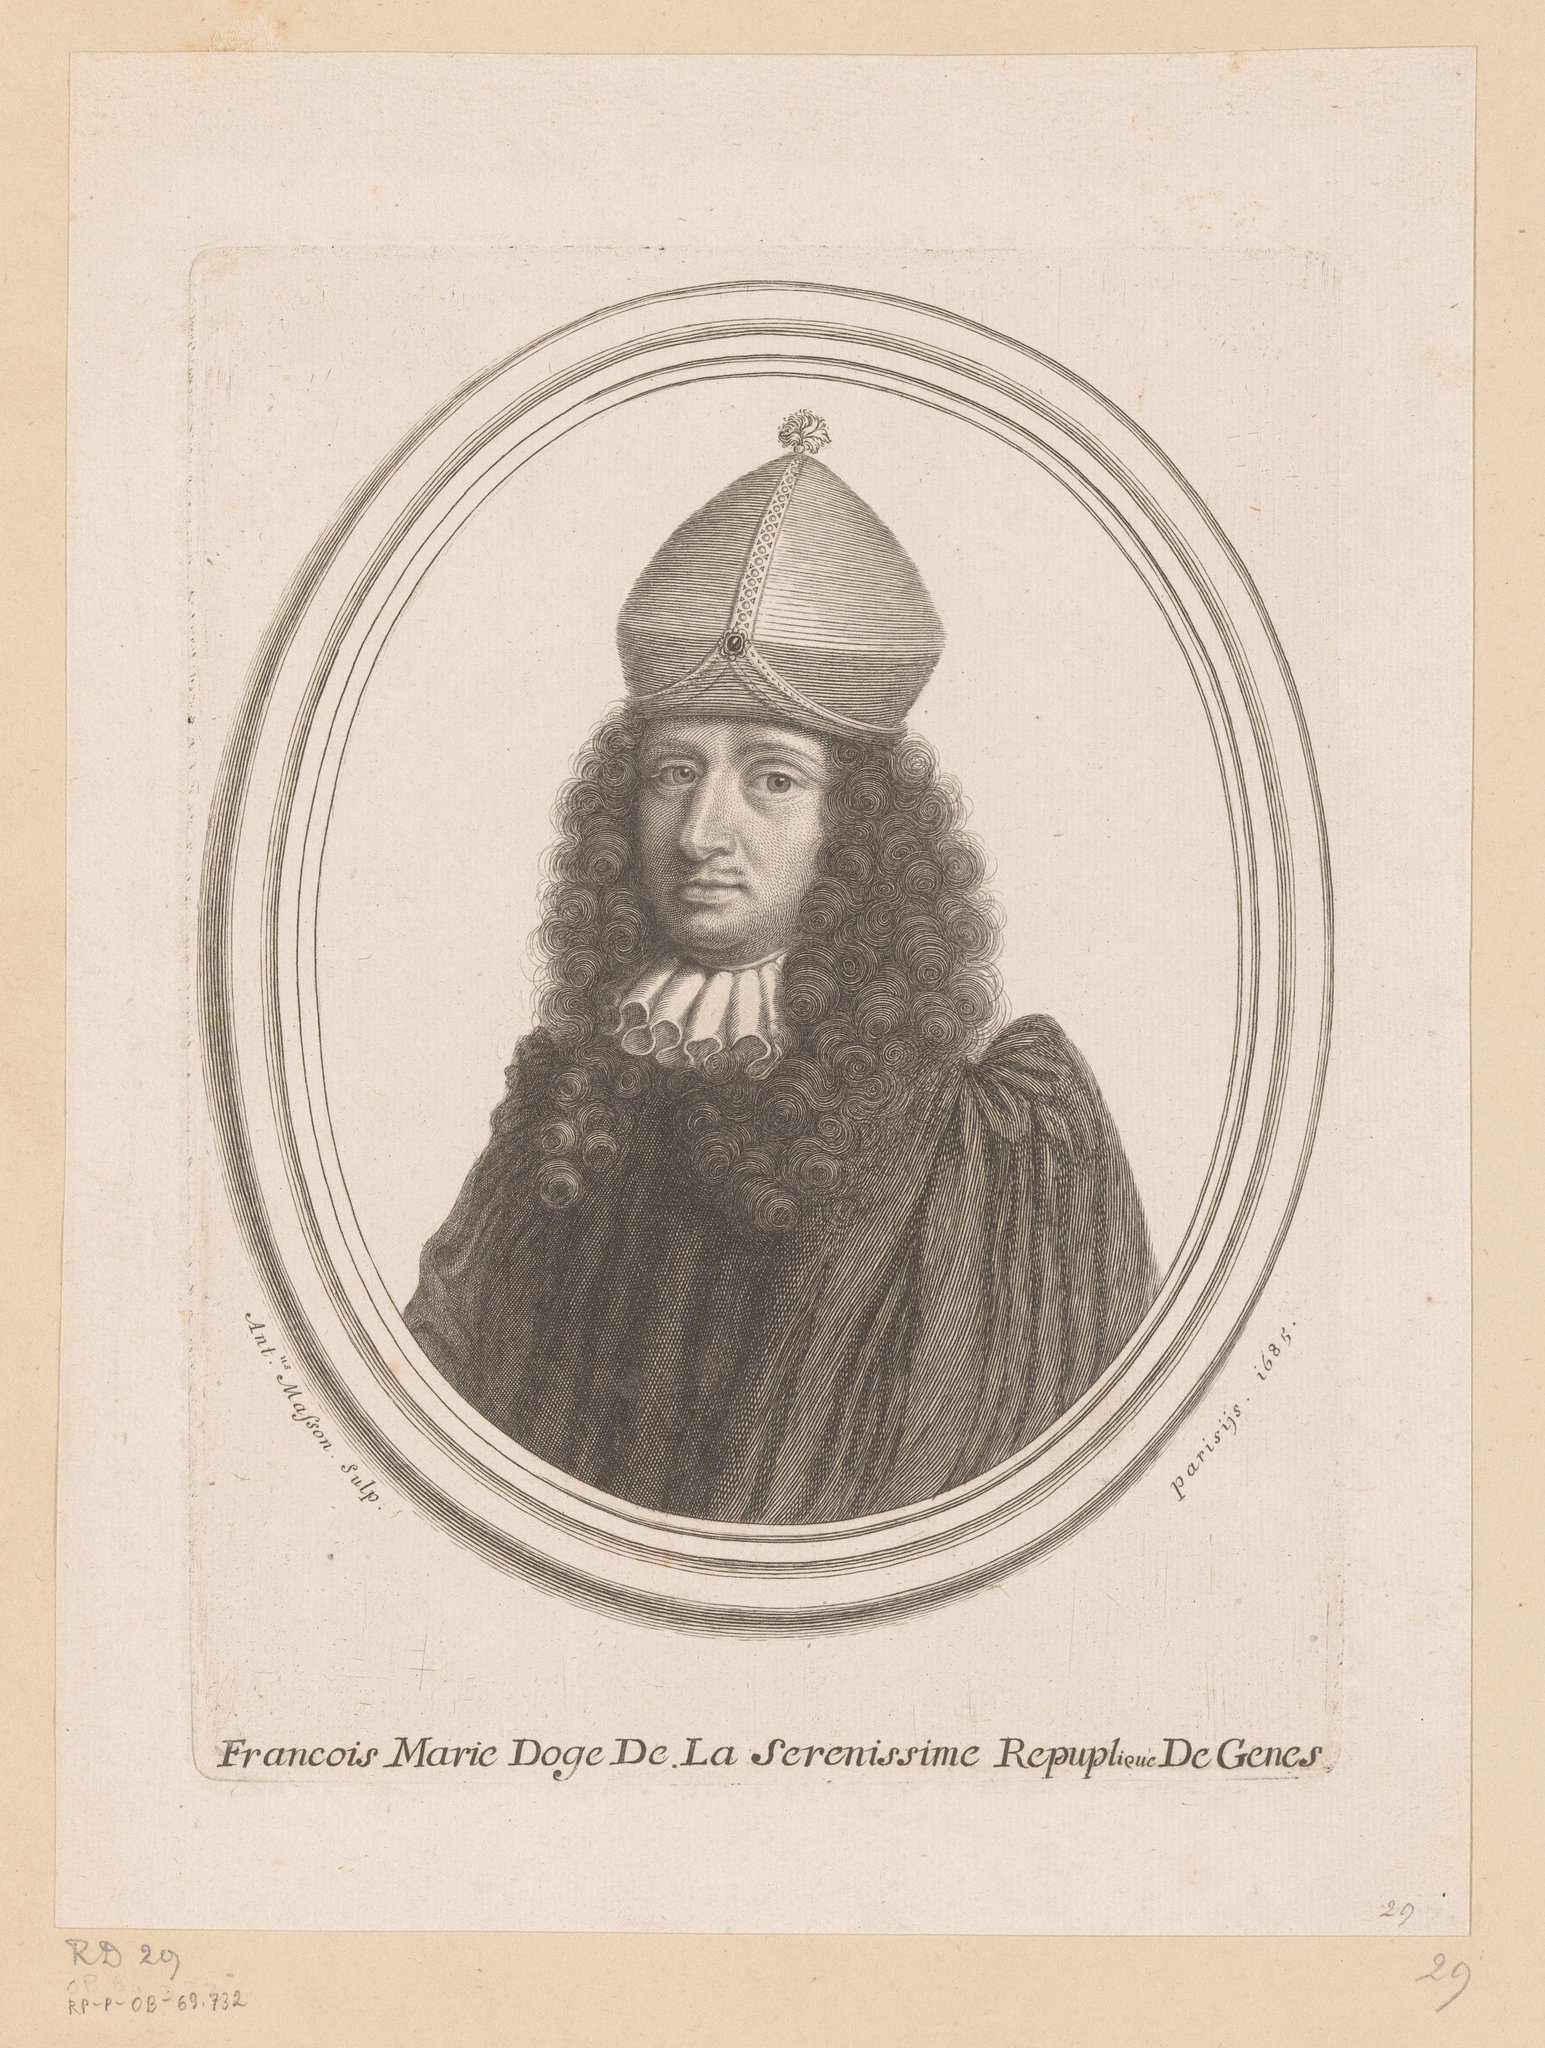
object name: print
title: Portret van Francesco Maria Imperiali Lercari, doge van Genua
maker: antoine masson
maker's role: print maker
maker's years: 1636-1700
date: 1685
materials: paper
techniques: engraving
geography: paris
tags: historical persons, ruler, sovereign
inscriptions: collector's mark: Lugt 240